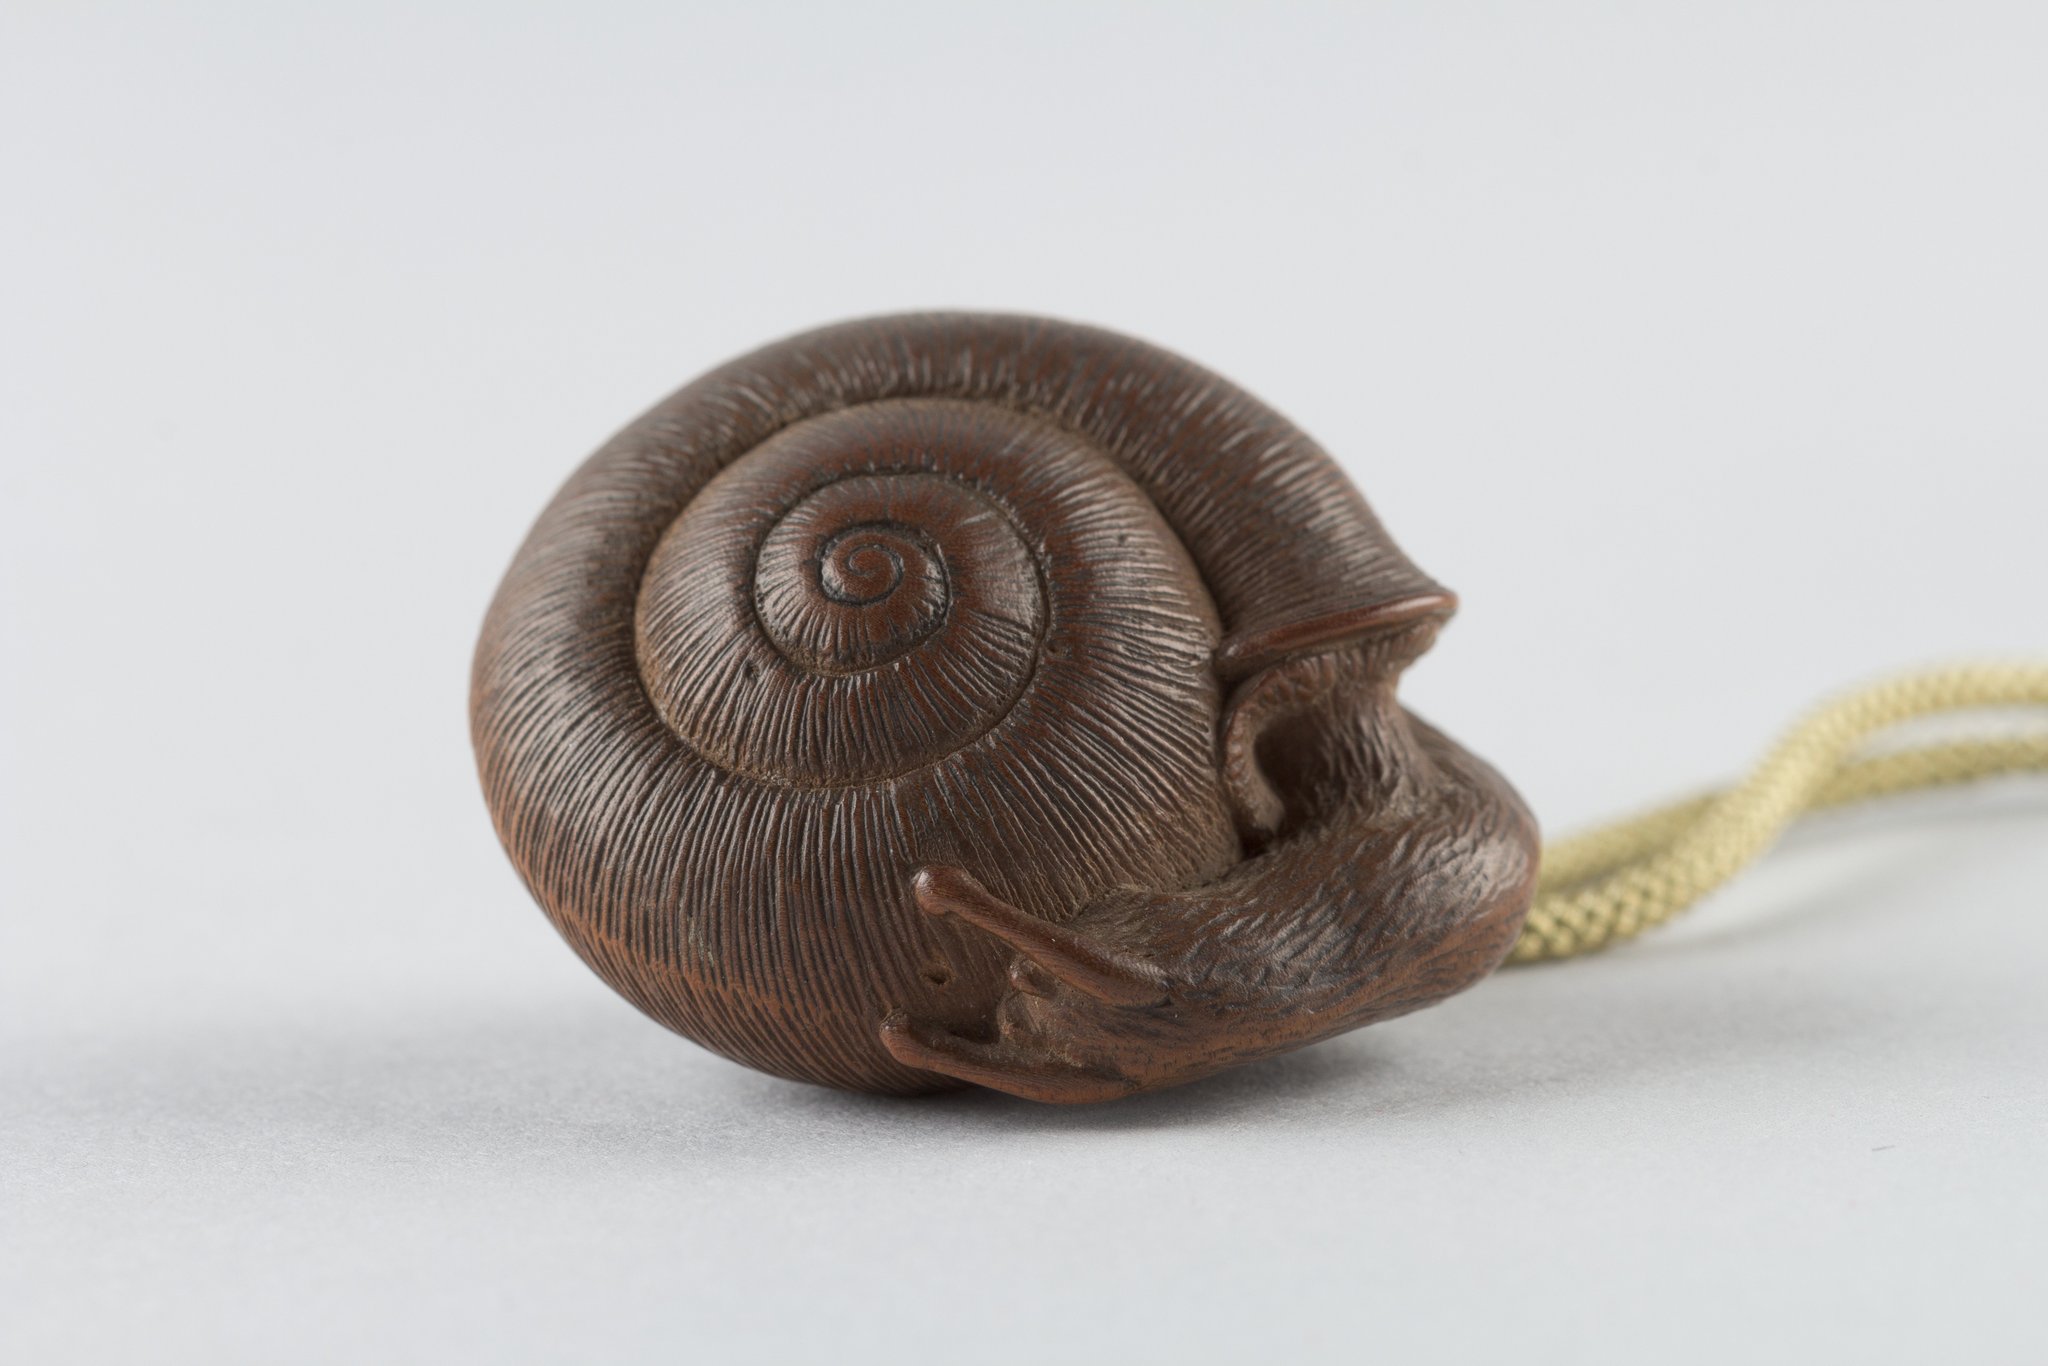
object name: netsuke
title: Netsuke of a Snail Emerging from its Shell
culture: japanese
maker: kokei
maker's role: artist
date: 1801-1900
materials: wood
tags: snails